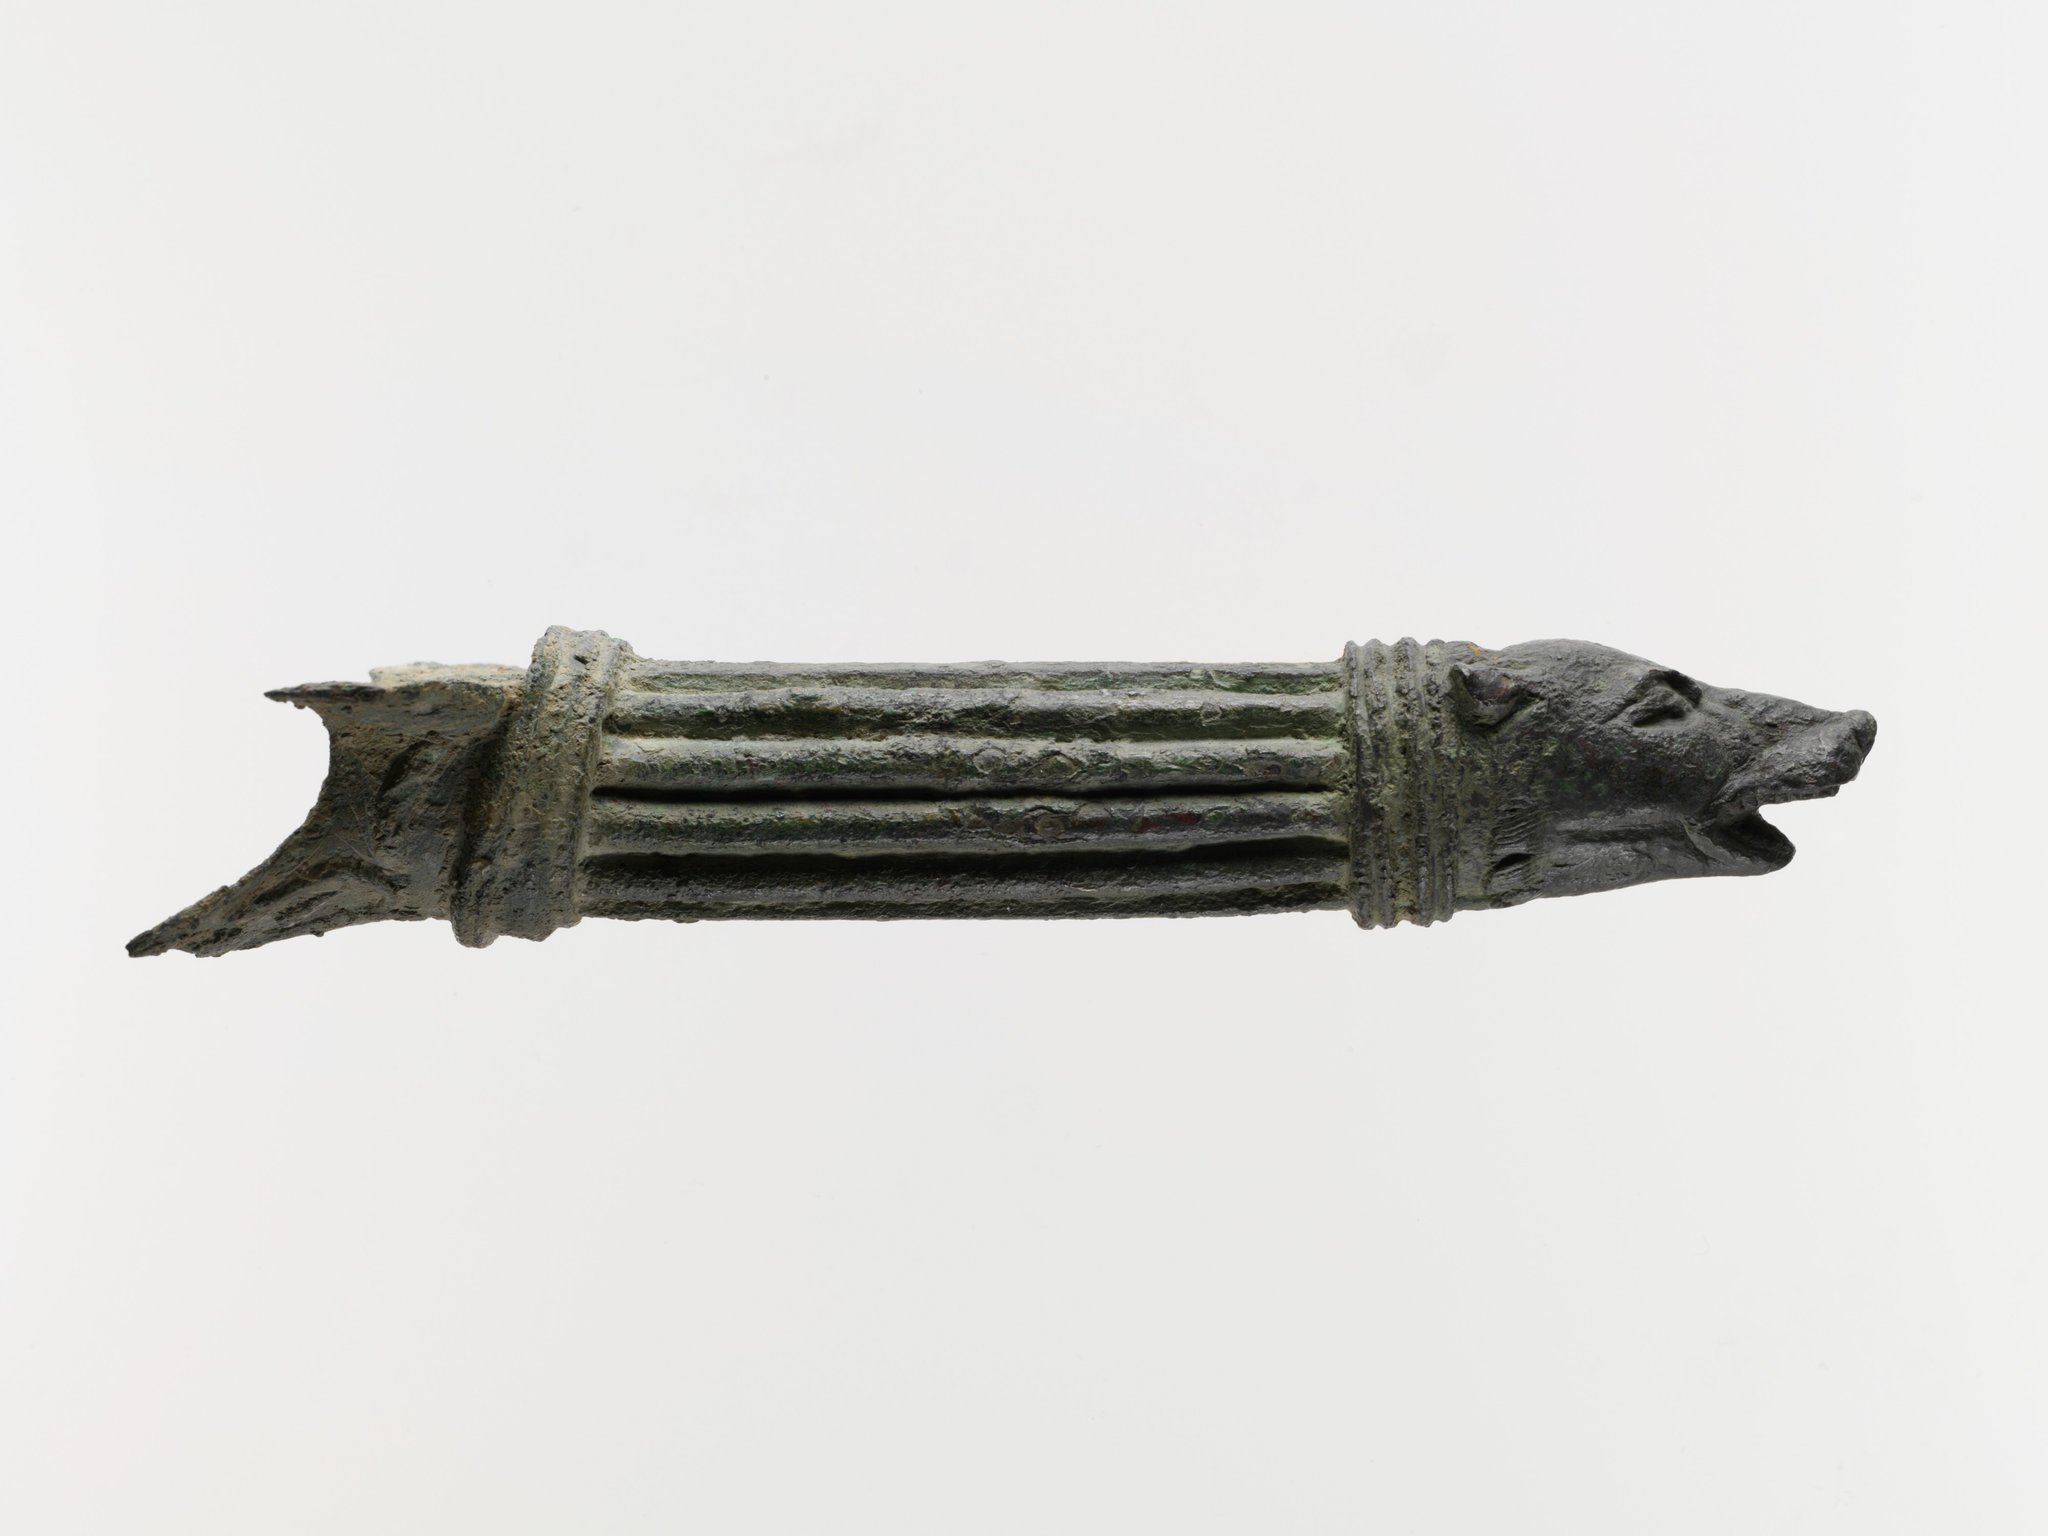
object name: handle of a patera with wolf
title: Bronze handle of a patera (shallow saucepan)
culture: roman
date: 1-100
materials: bronze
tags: animals